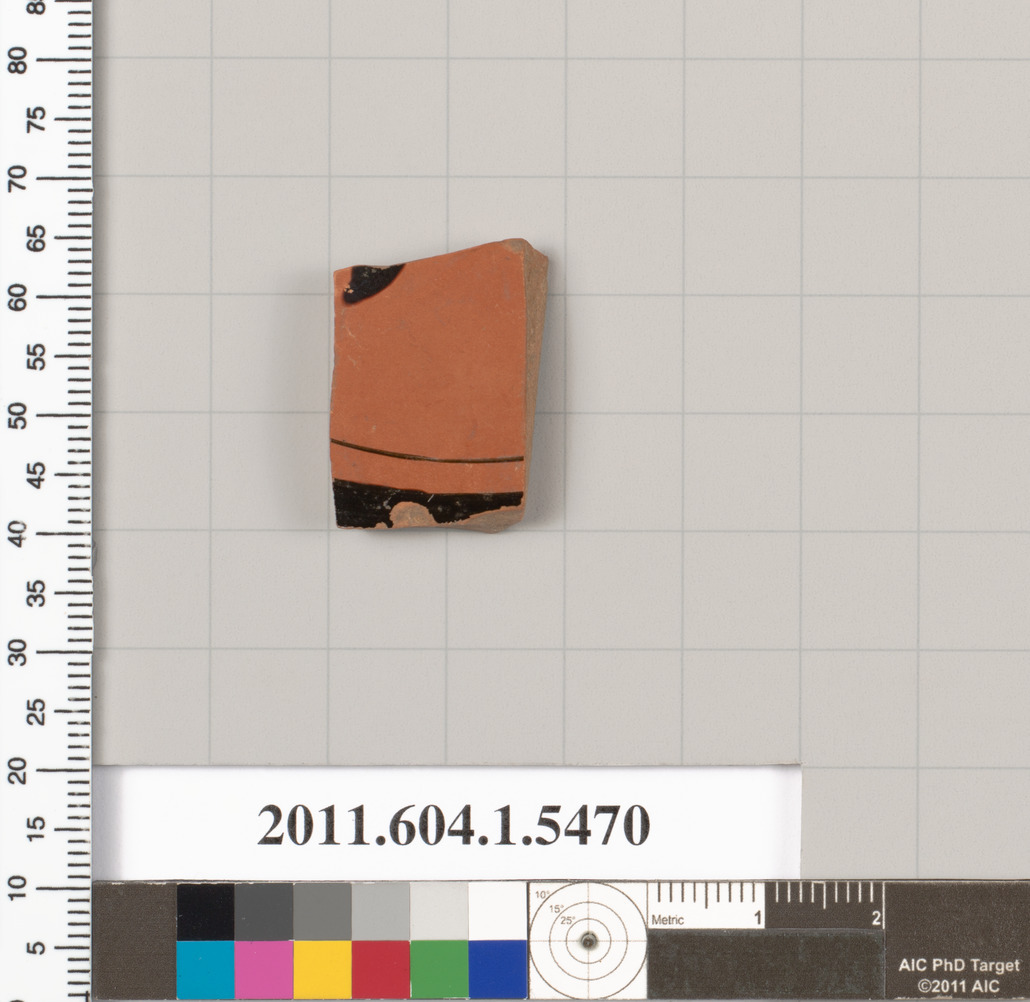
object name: kylix fragment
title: Terracotta fragment of a kylix (drinking cup)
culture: greek, attic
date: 510-490 BCE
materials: terracotta